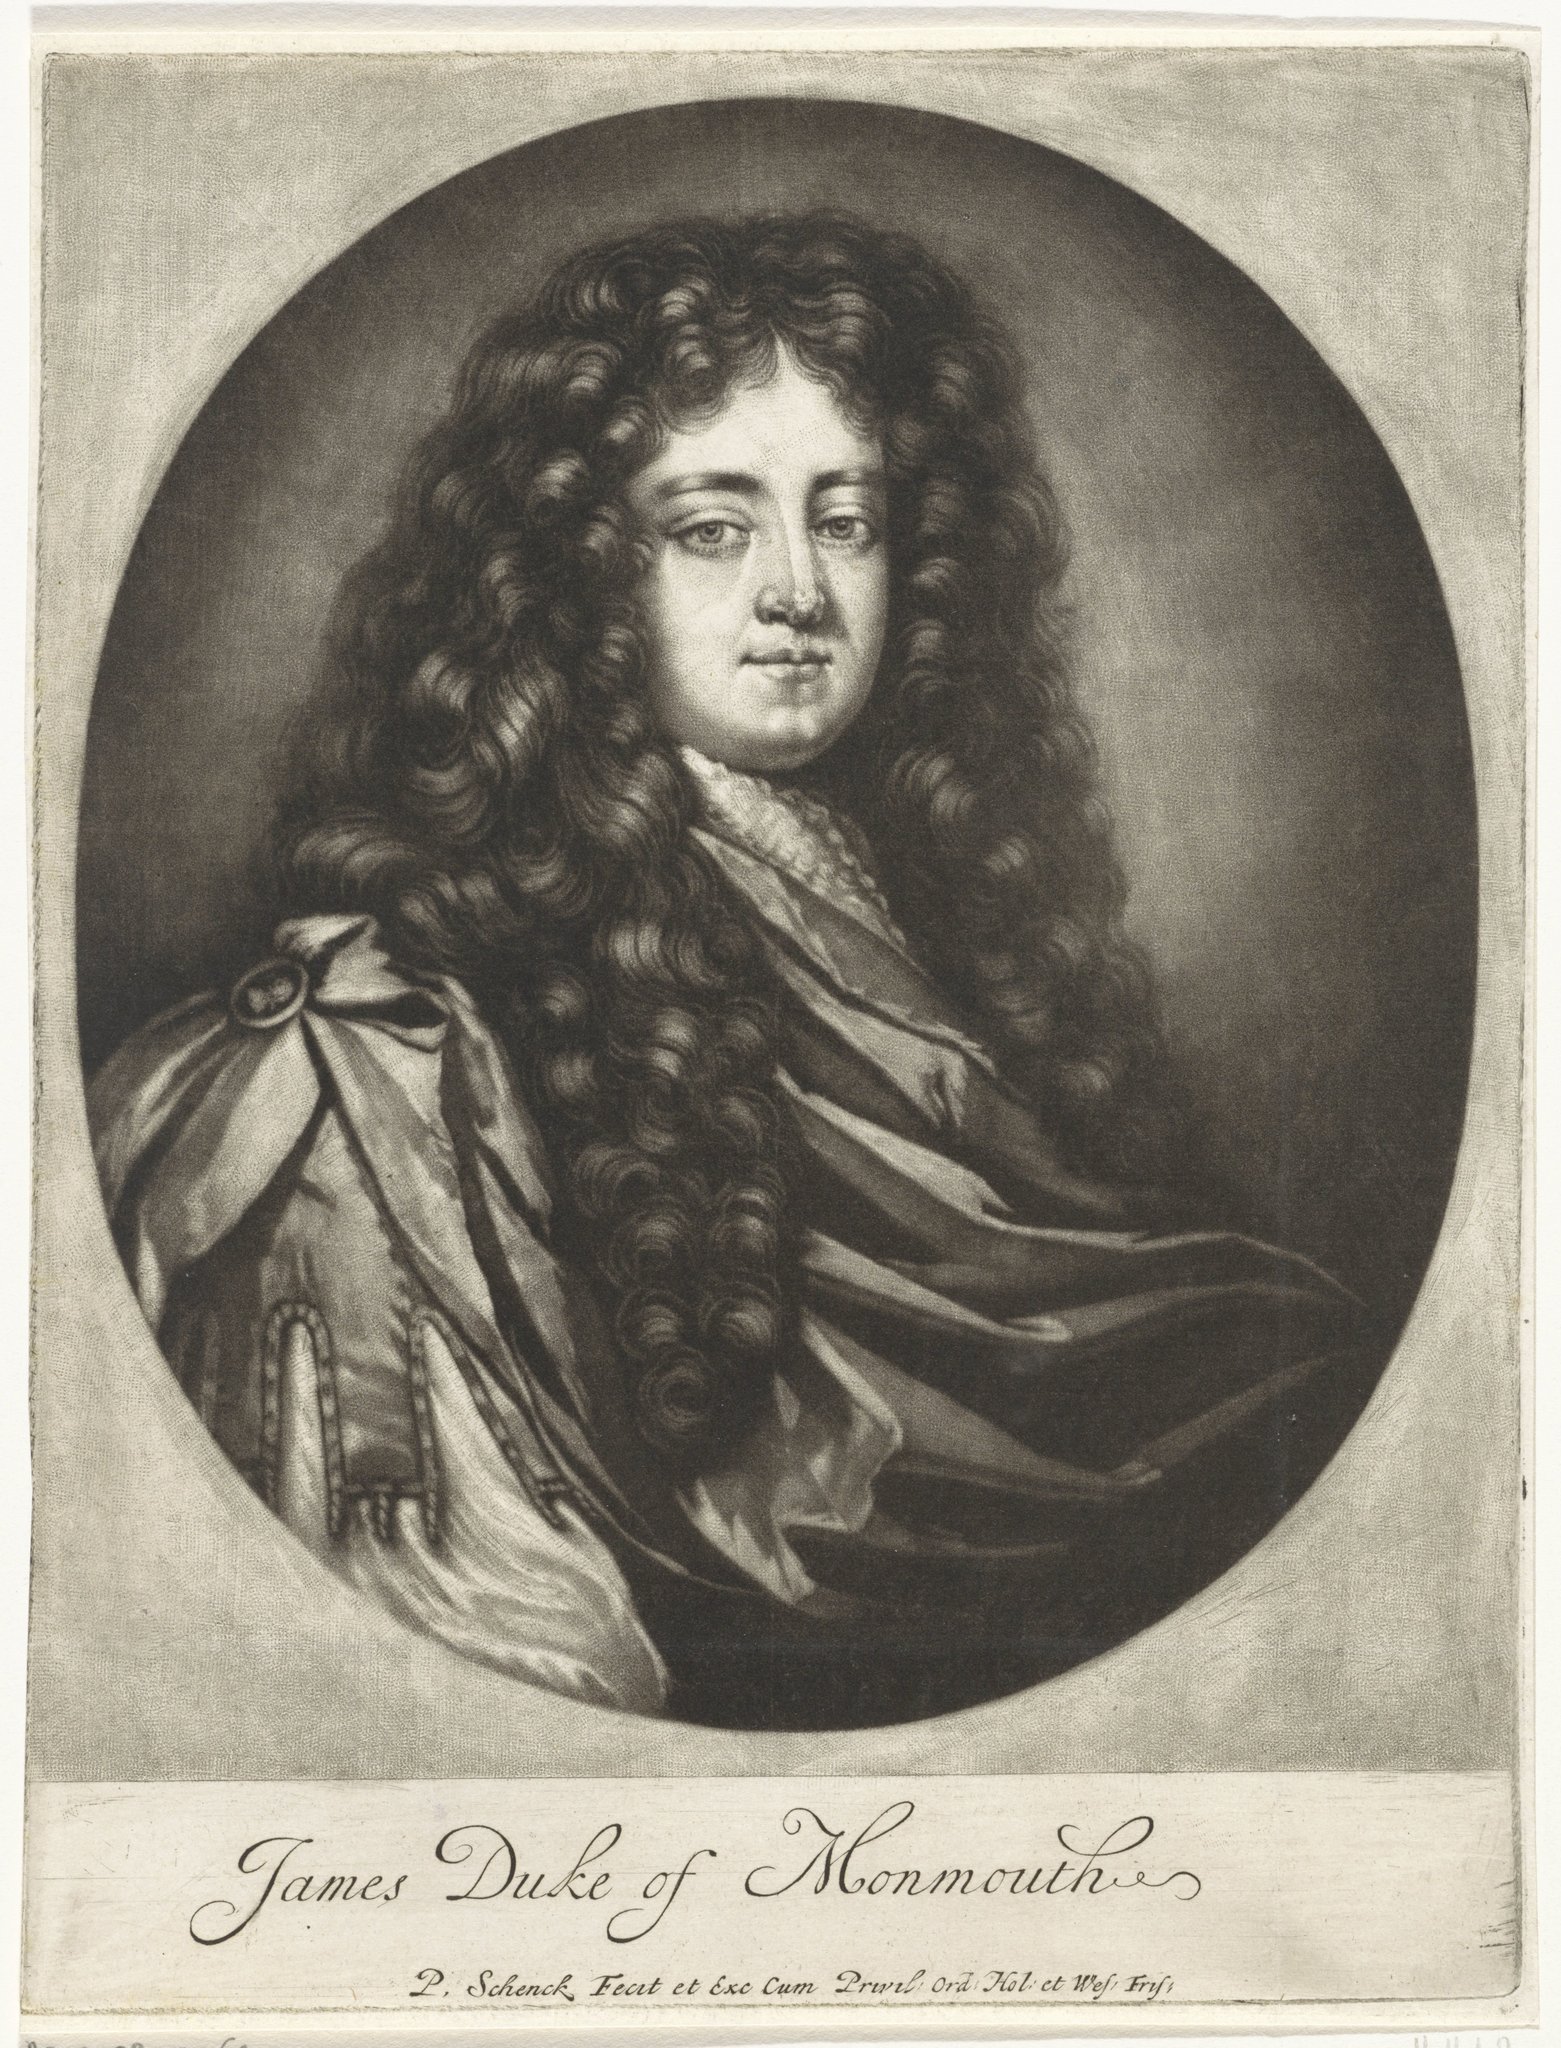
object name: print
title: Portret van James Scott hertog van Monmouth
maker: pieter schenk (i)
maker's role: print maker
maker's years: 1660-1711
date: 1670-1713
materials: paper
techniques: engraving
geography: amsterdam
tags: rotterdam, london, wig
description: Deze prent is de pendant van Hollstein nr. 811, door dezelfde prentmaker.